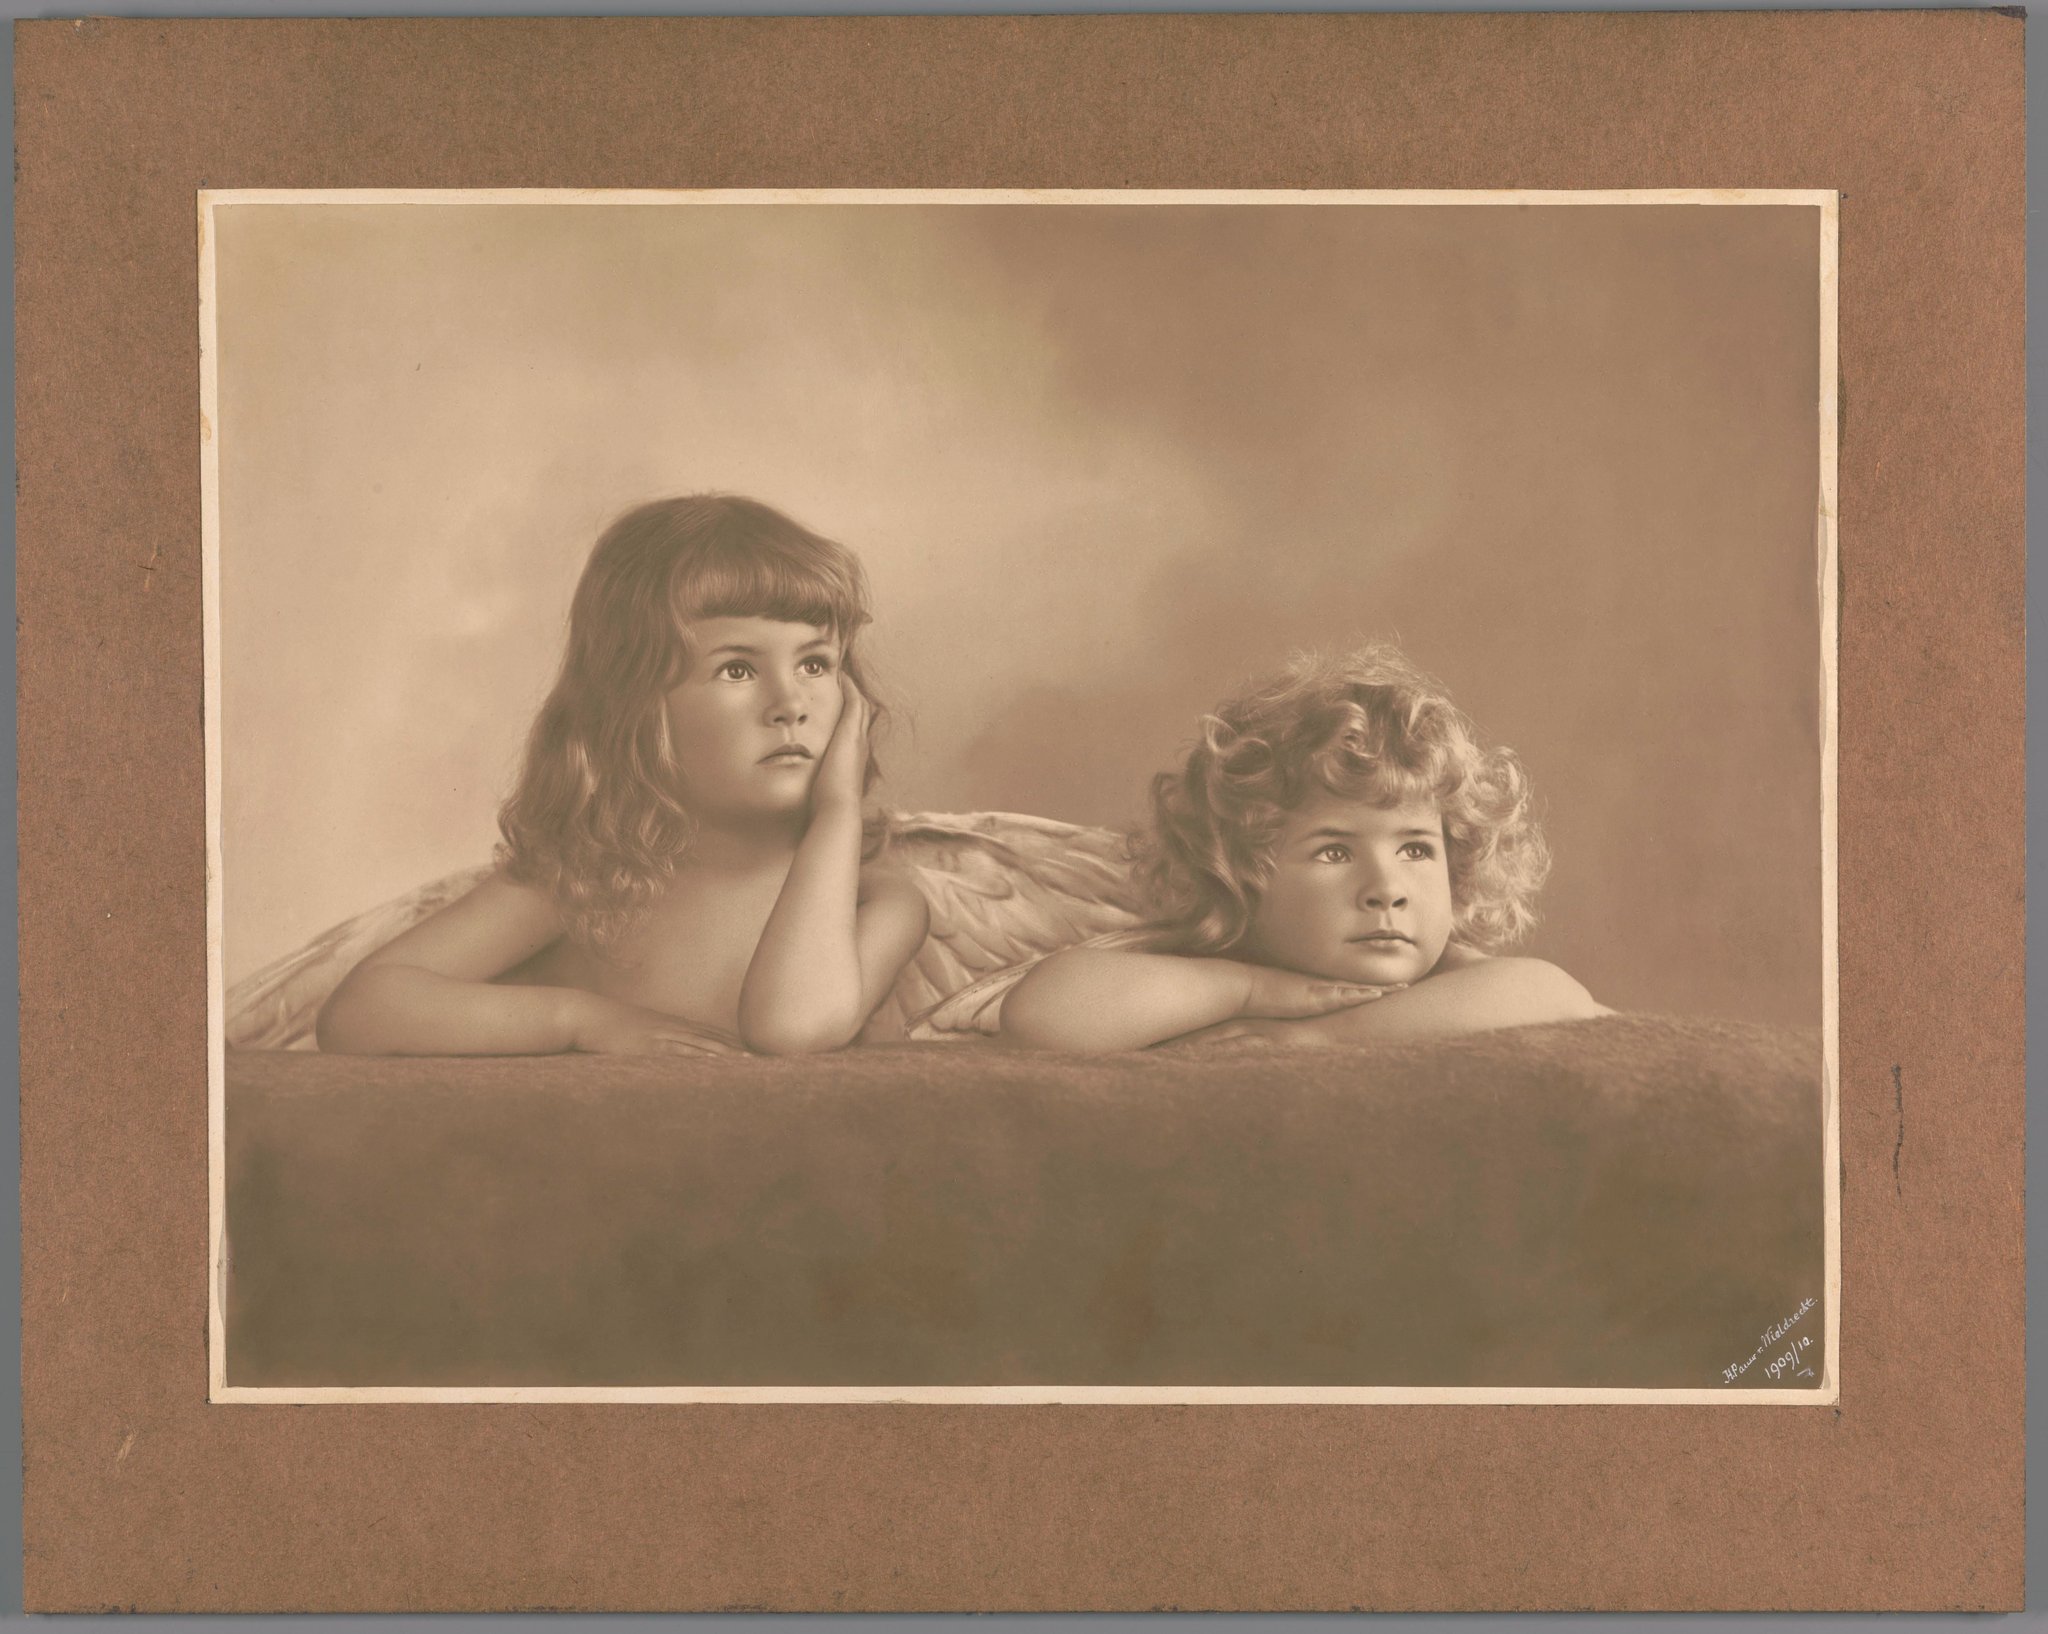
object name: photograph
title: Portret van Agnes Renée en Irène Heloïse Pauw van Wieldrecht, dochters van de fotograaf, in een pose die ontleend is aan de putti op de Sixtijnse Madonna van Rafaël (Dresden, Galerie Alte Meister)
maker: henry pauw van wieldrecht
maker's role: fotograaf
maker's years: 1863-1912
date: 1909-1910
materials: paper, photographic support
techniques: gelatin silver print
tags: agnes renée pauw van wieldrecht, irène heloïse pauw van wieldrecht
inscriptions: signature and date: ‘H. Pauw v. Wieldrecht. / 1909-10.’